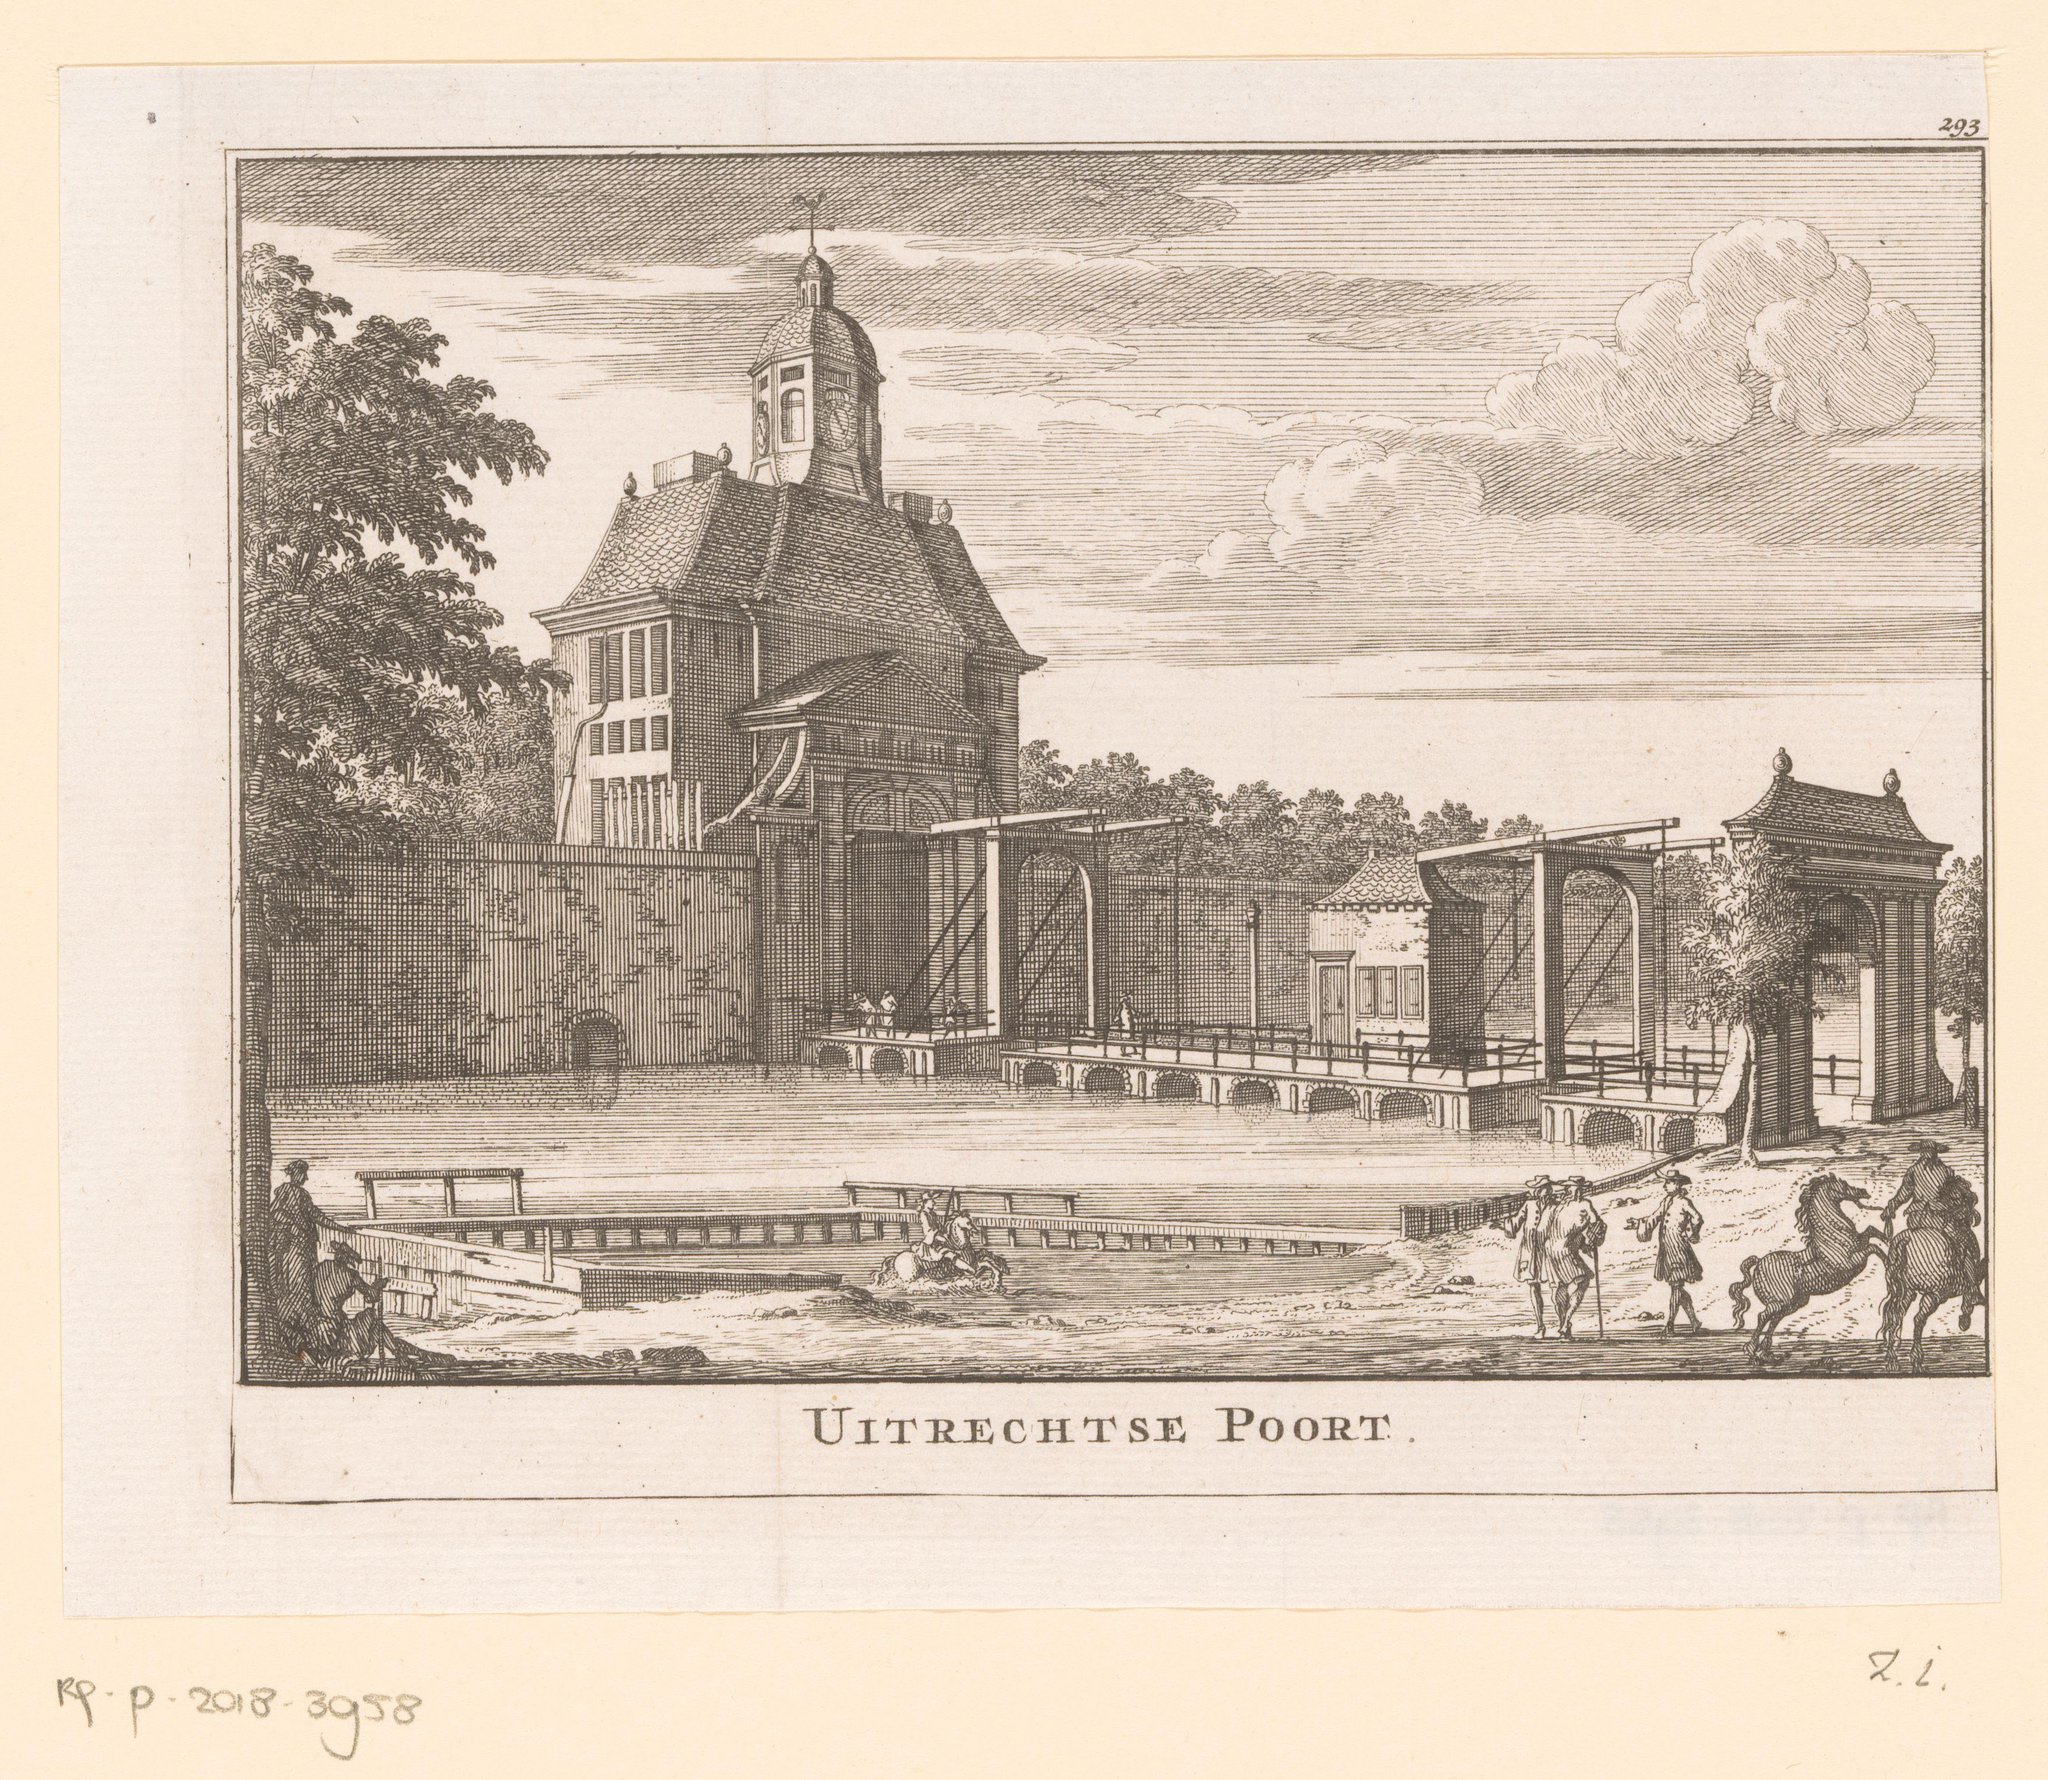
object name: print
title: Uitrechtse poort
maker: Anonymous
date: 1650-1750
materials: paper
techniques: engraving, etching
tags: bridge in city across river, canal, etc., city-gate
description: Gezicht op de Utrechtsepoort in Amsterdam, met op de voorgrond enkele figuren en een ruiter met twee paarden. Linksvoor het paardenwed, met daarin een man te paard. Rechtsboven genummerd "293".